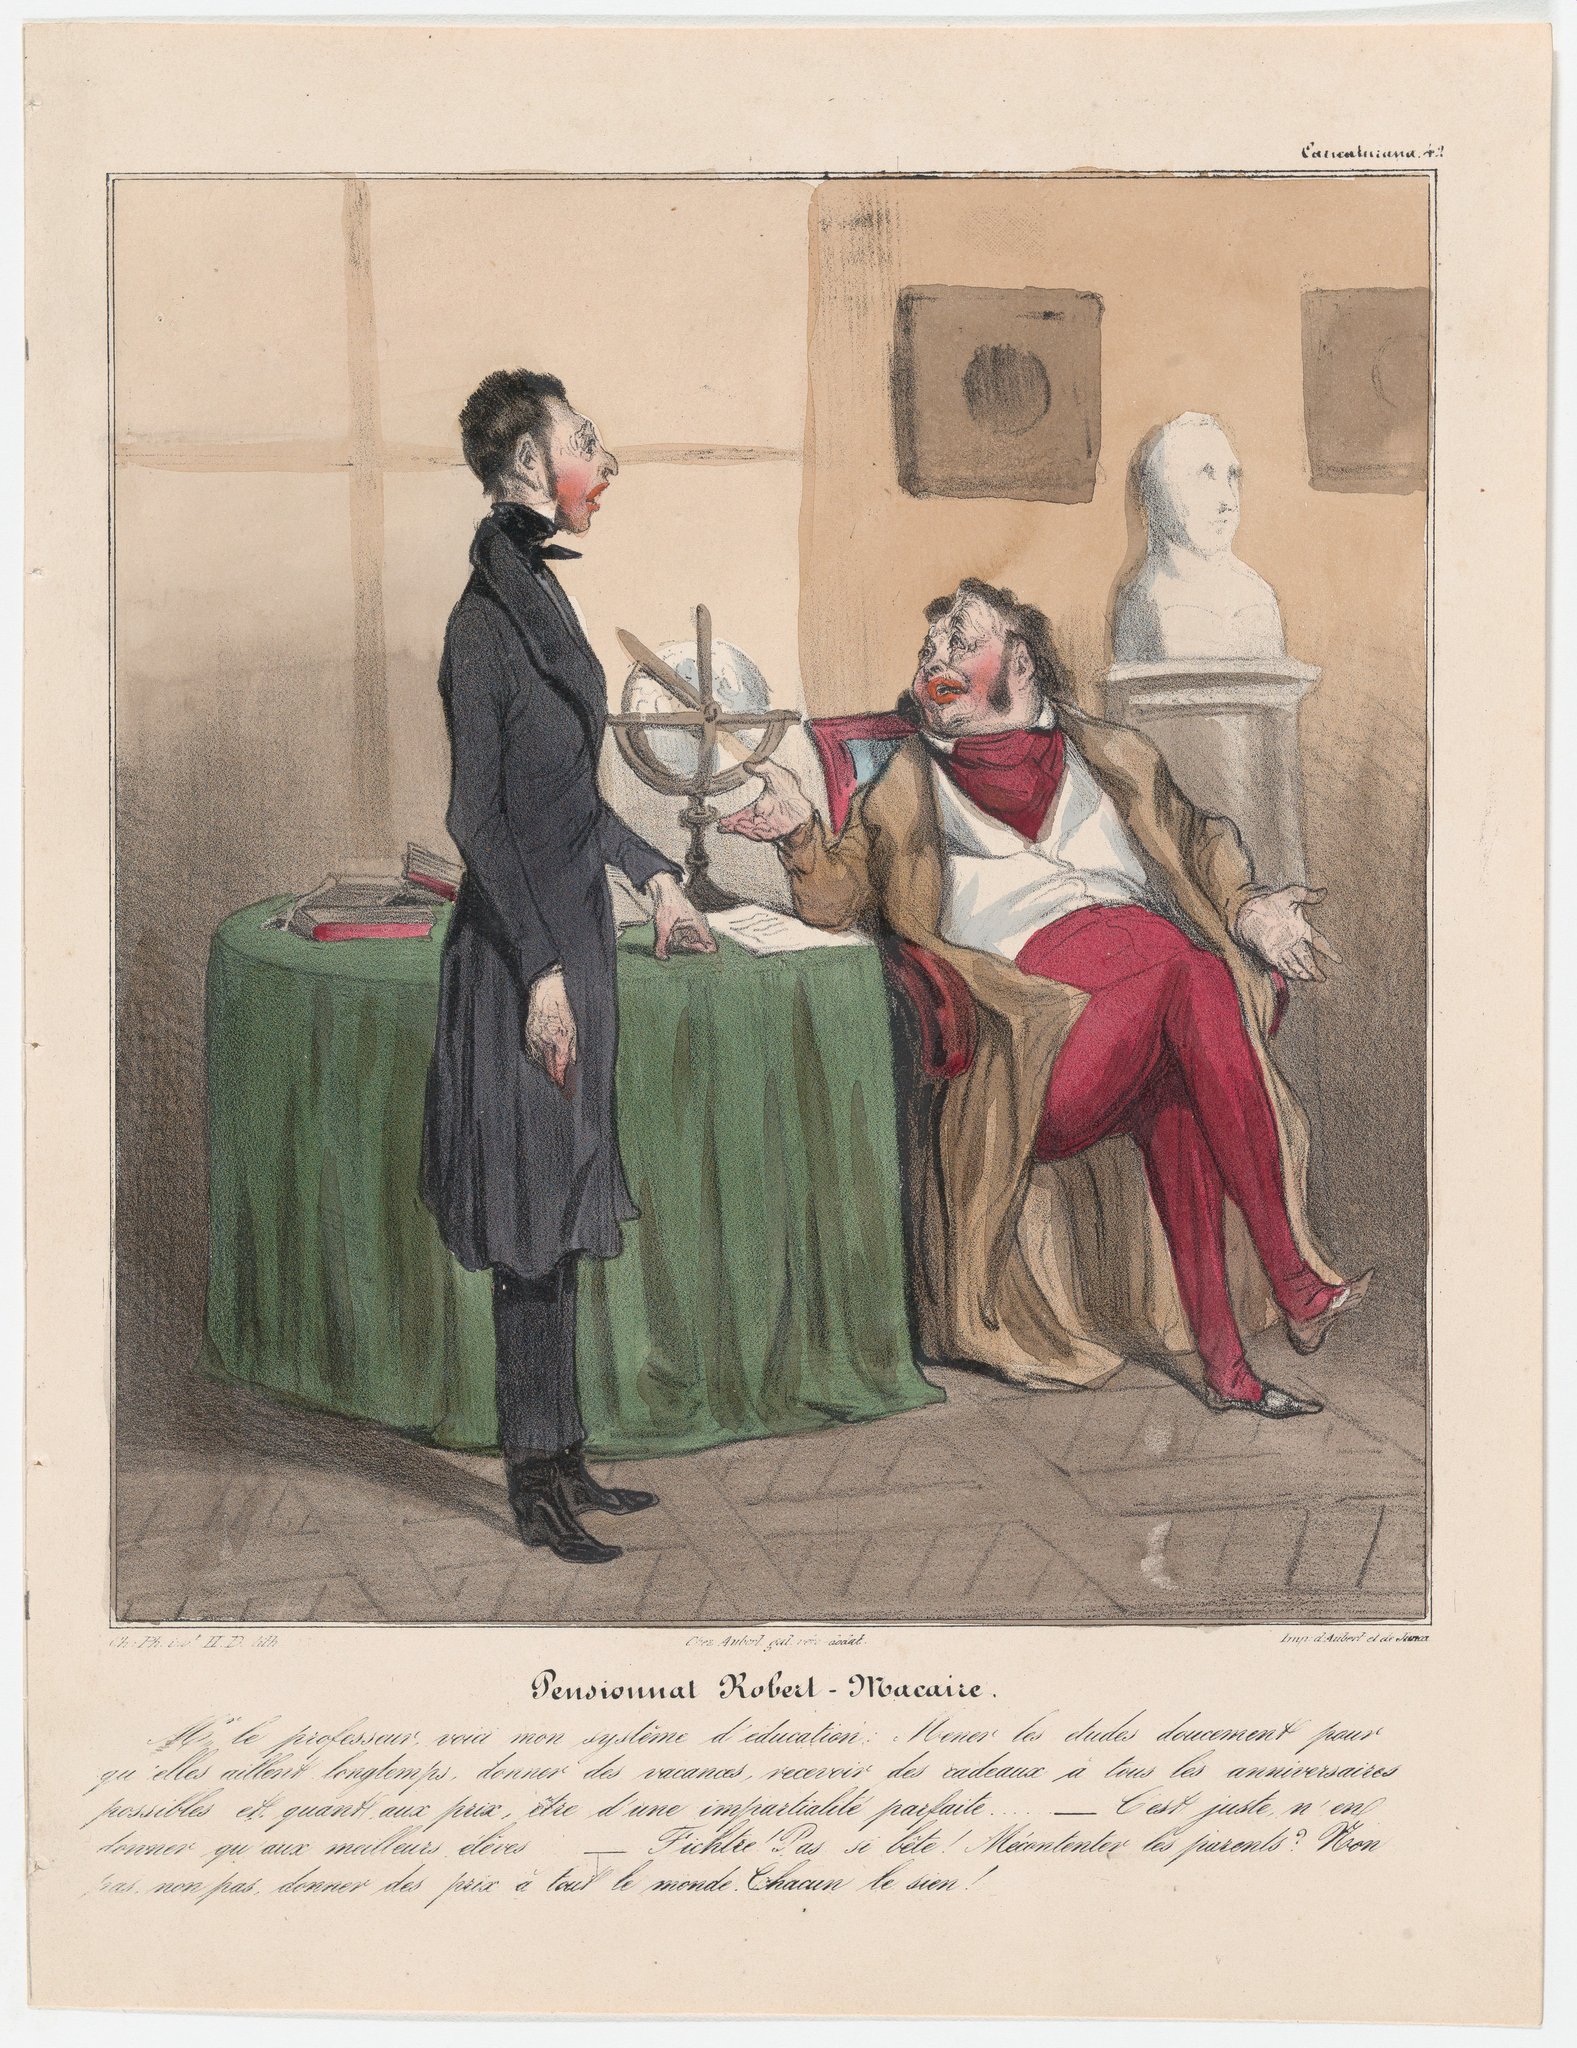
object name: print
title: Plate 42: Robert Macaire's boarding school, from 'Caricaturana,' published in Les Robert Macaires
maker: honoré daumier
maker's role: artist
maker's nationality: french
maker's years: 1808-1879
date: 1838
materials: paper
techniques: lithograph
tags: satire,men